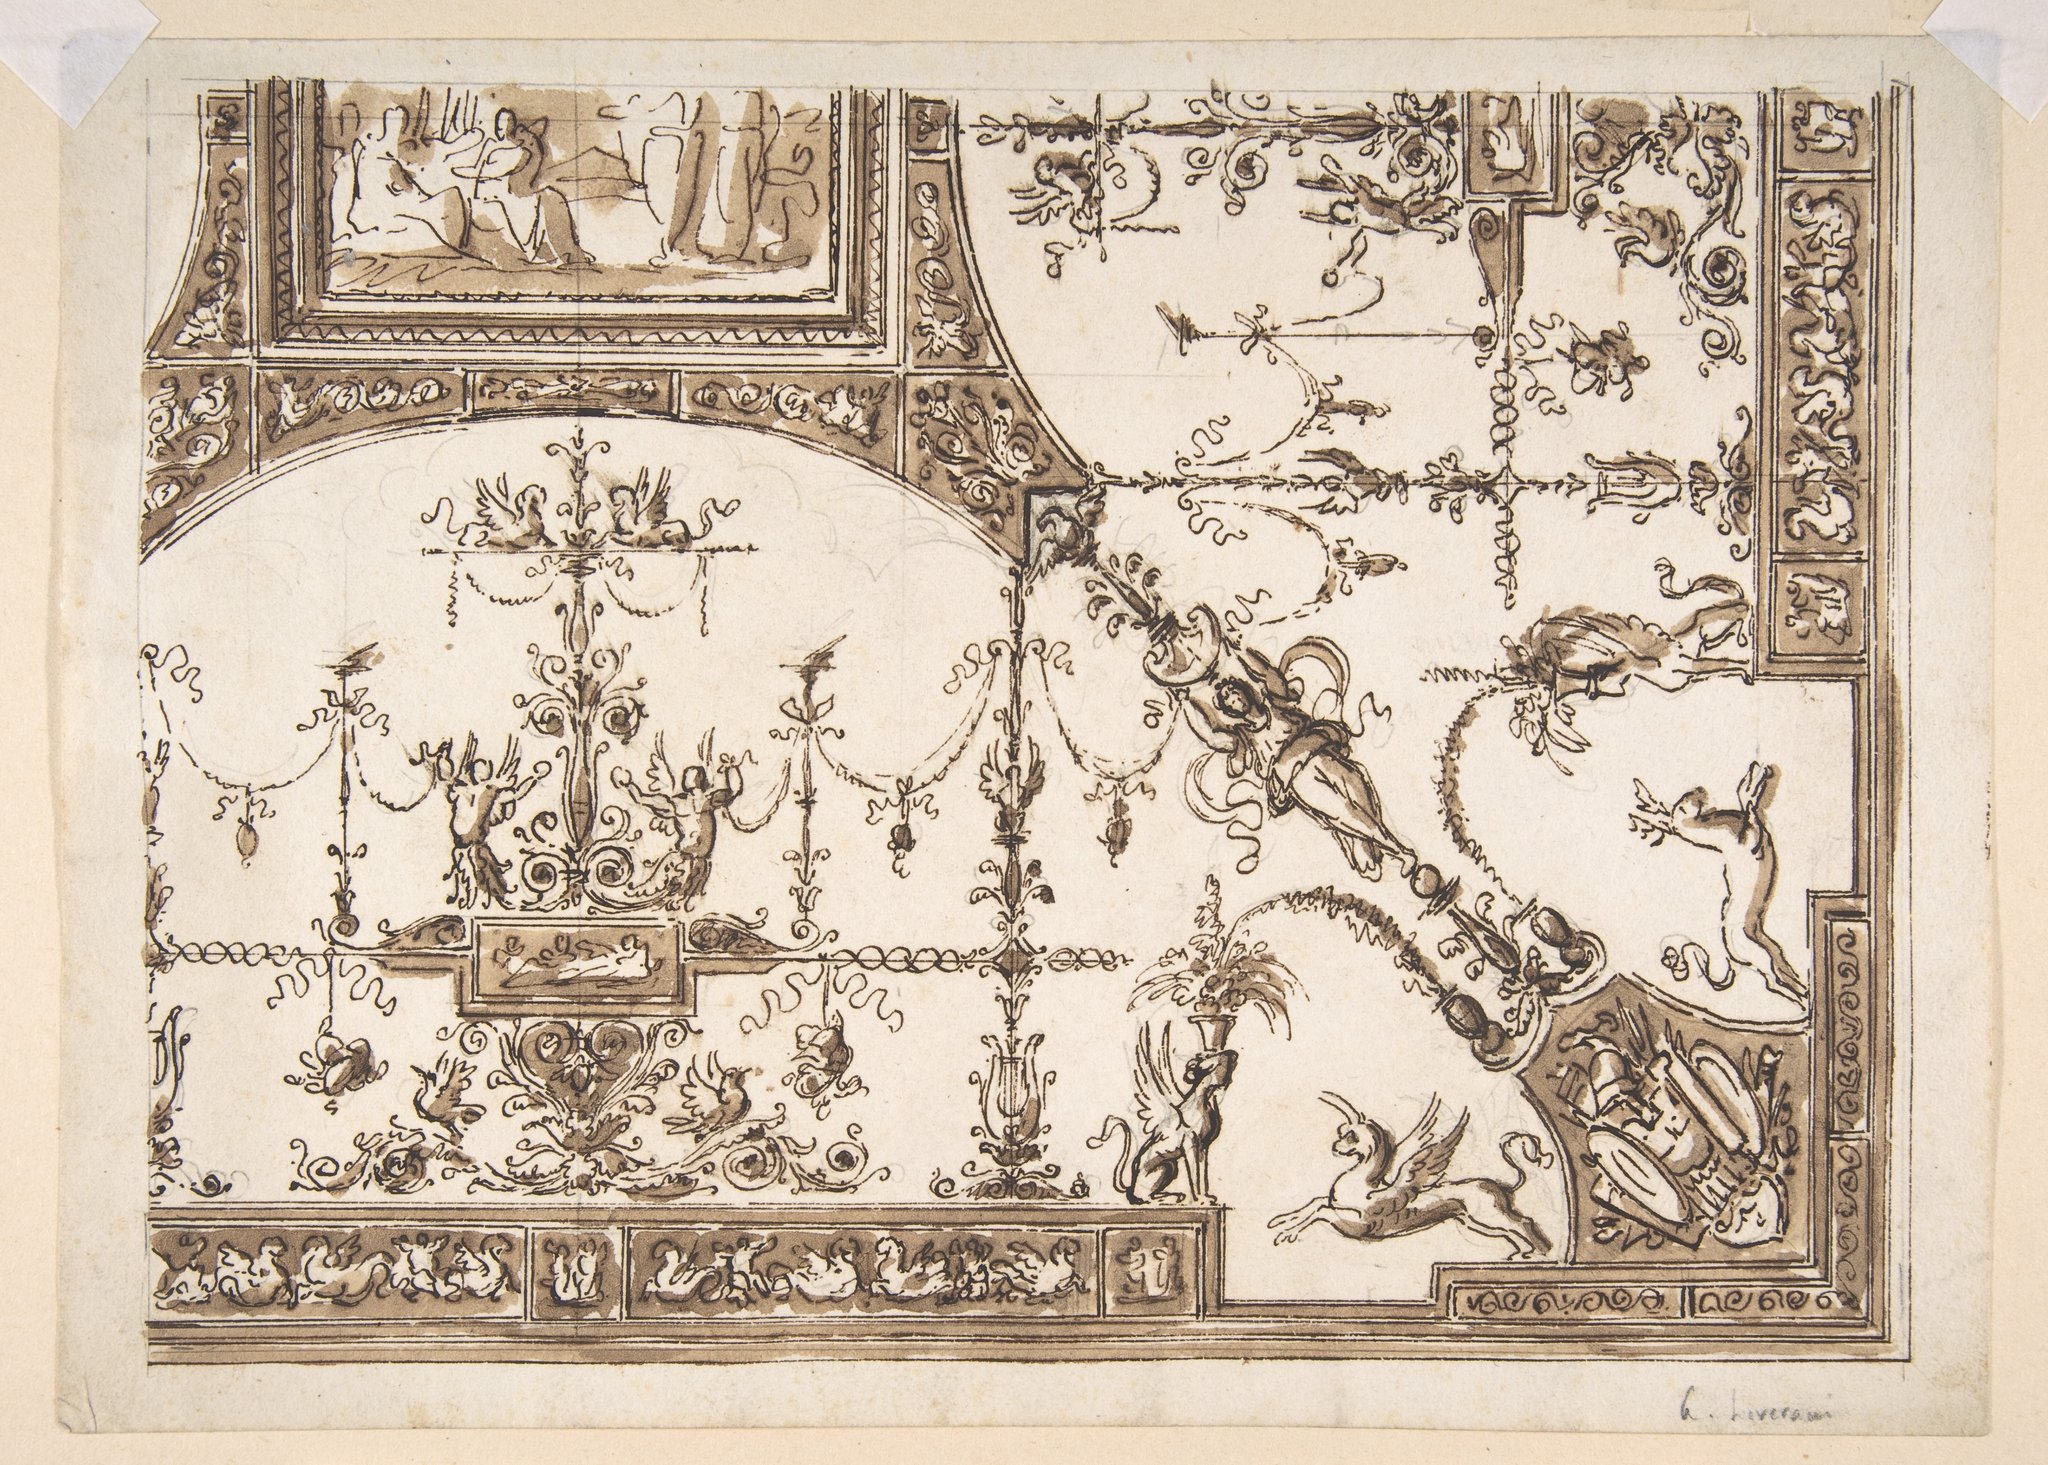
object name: drawing ornament architecture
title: Ceiling Design with Grotesques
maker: antonio liverani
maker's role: artist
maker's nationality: italian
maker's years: 1795-1878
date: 1801-1900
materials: graphite, ink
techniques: brush, pen, drawing, wash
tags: grotesques,sphinx,deer